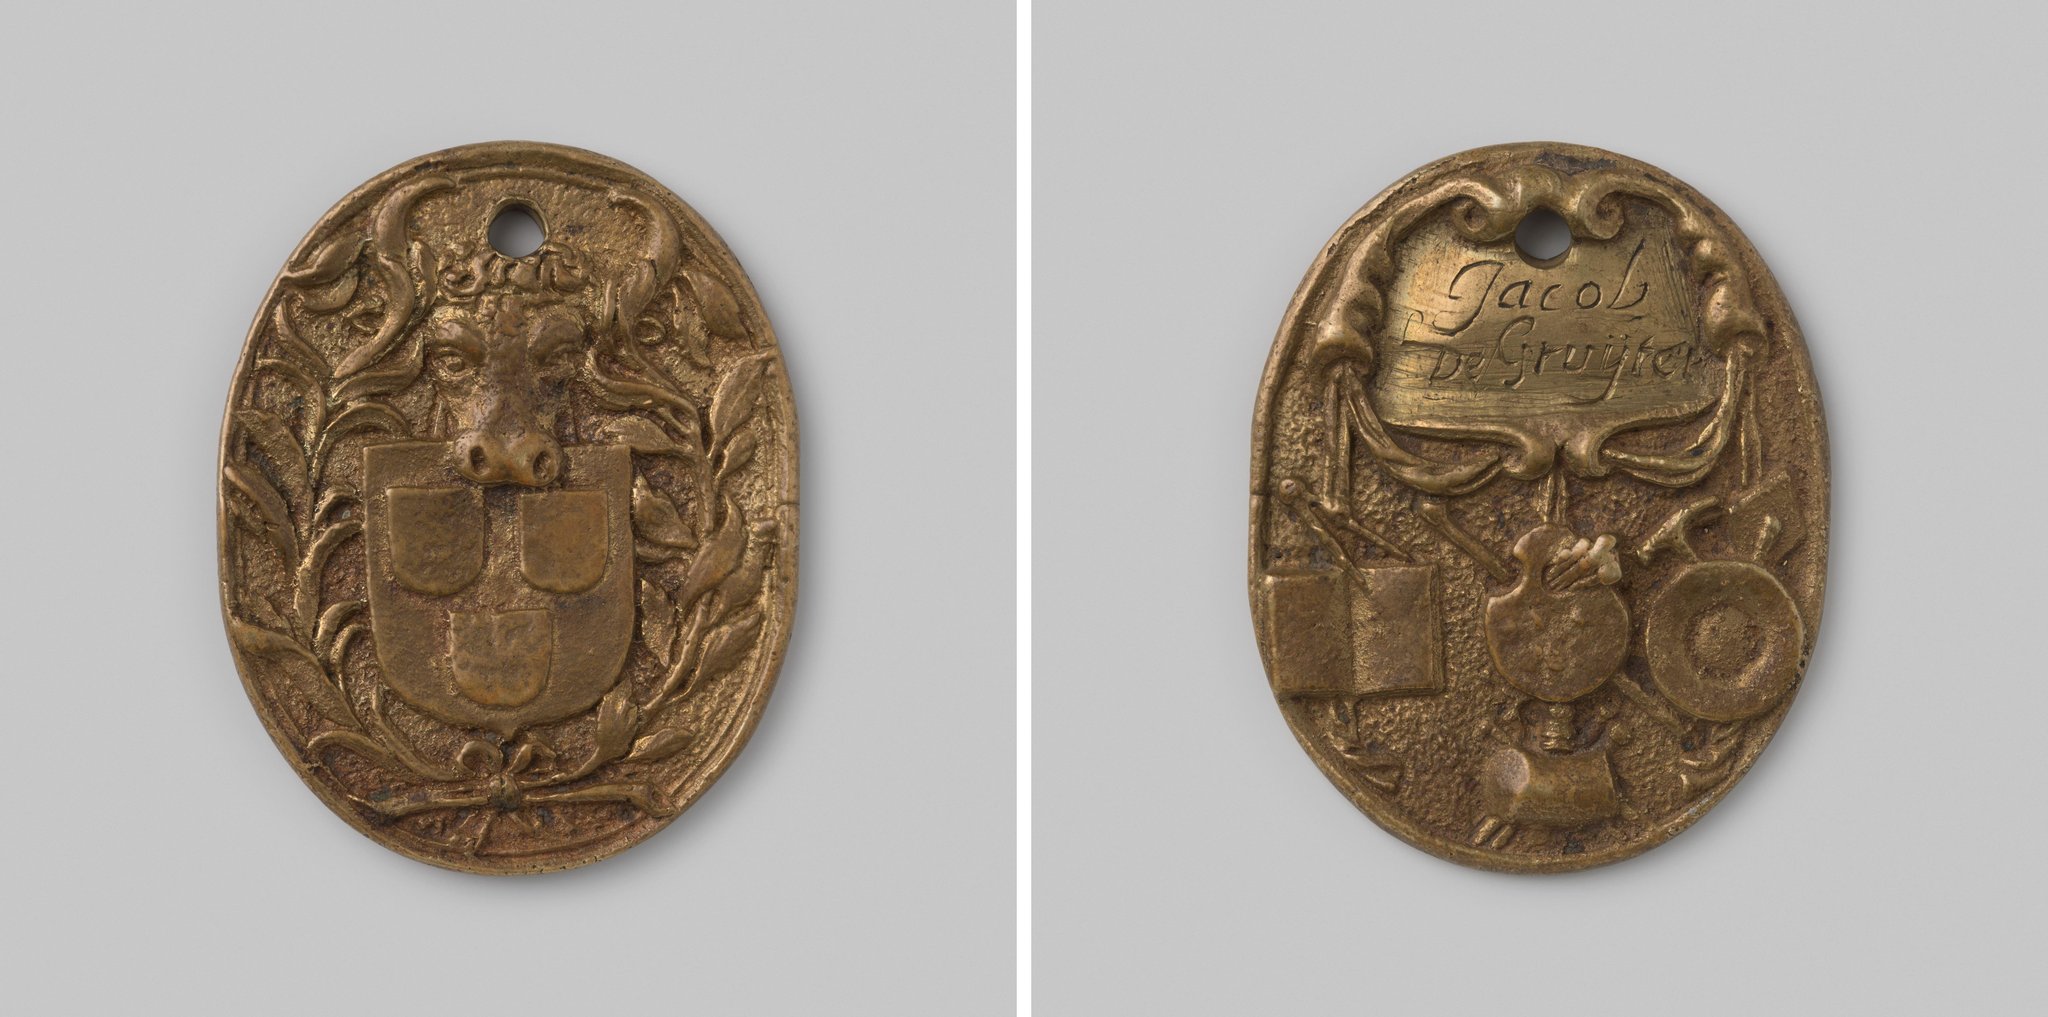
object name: history medal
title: Presentiepenning van Jacob de Gruijter als lid van het Sint Lucas- of Schilders- en konstwerkersgilde te Middelburg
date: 1650-1680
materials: brass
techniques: casting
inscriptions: inscription: ‘Jacob / De Gruijter’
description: Gegoten ovalen messing penning, op de voorzijdetussen lauwertakken een Lucasschild waarboven een ossenkop, op de keerzijde een inscriptieruimte met draperiën boven diverse schildersgereedschappen, op naam van Jacob de Gruijter, met gat